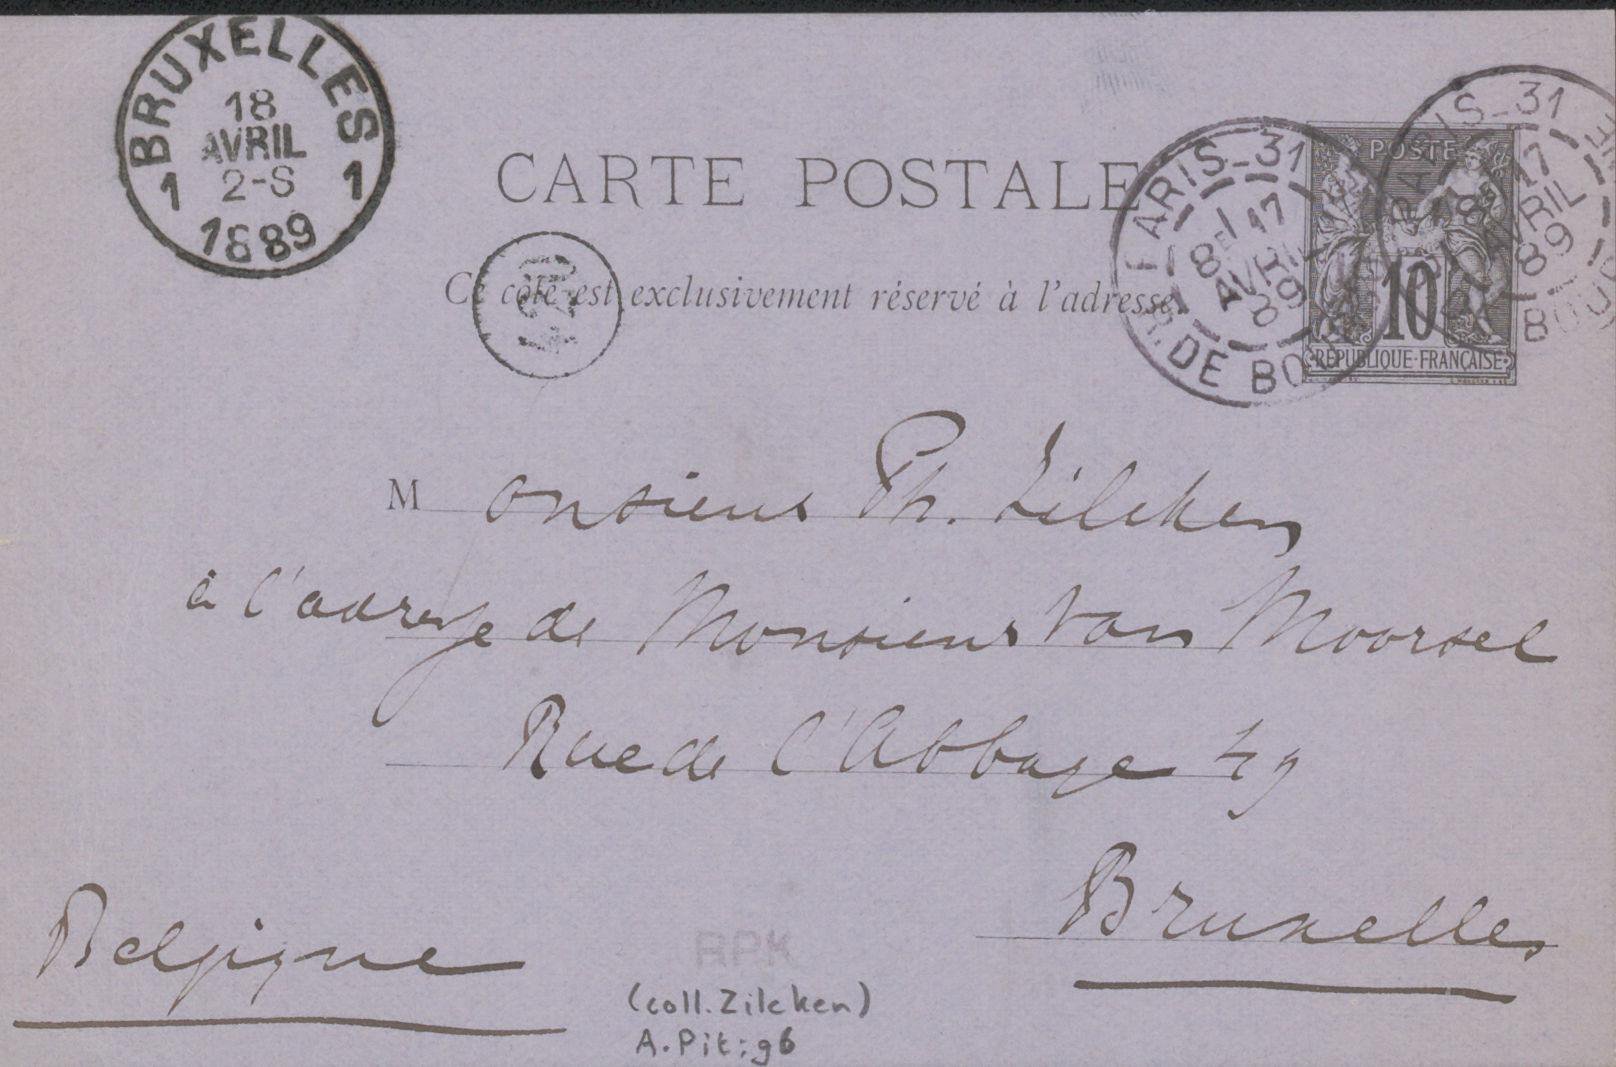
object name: postcard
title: Briefkaart aan Philip Zilcken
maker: adriaan pit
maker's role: print maker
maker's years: 1860-1944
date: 1889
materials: cardboard, ink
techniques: pen, writing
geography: paris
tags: painter, draughtsman, philip zilcken, the hague, brussels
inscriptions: collector's mark: ‘RPK’